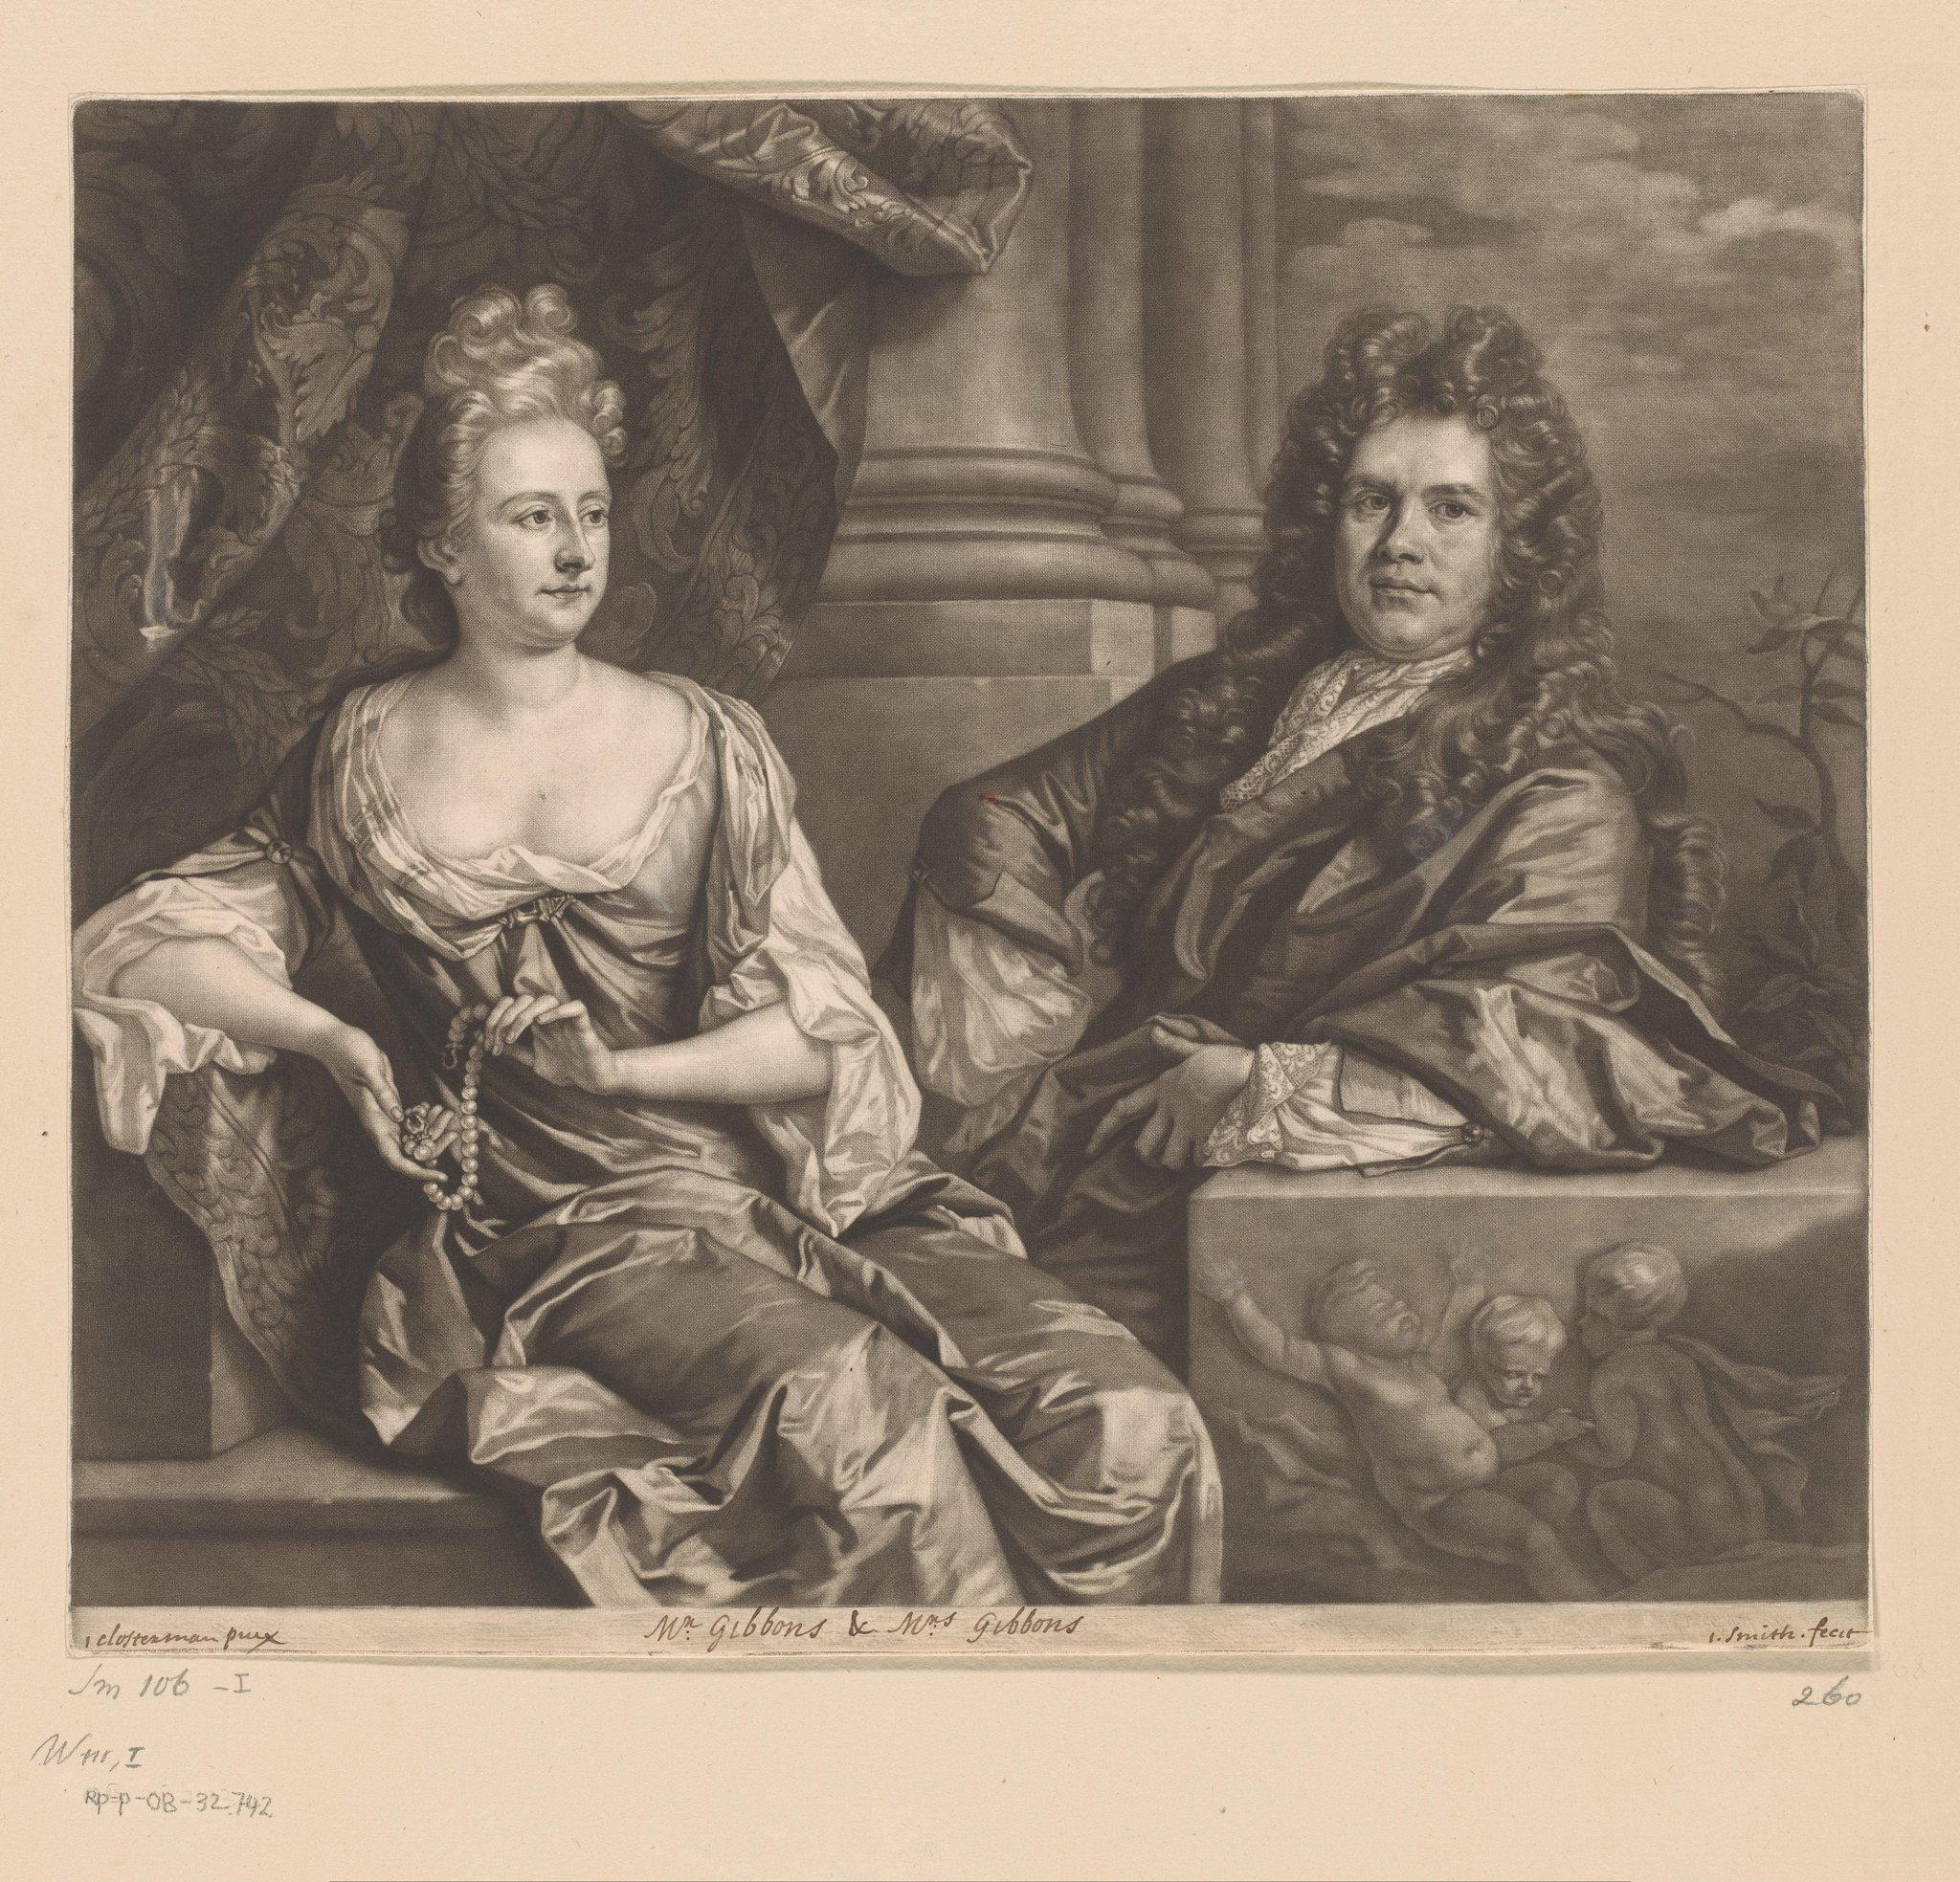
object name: print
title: Portret van Grinling en Elizabeth Gibbons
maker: john smith (prentmaker/ uitgever)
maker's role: print maker, publisher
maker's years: 1652-1743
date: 1691-1742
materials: paper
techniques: mezzotint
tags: london, sculptor, grinling gibbons, historical persons, couple of lovers, cupids: 'amores', 'amoretti', 'putti'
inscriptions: collector's mark: Lugt 240, annotation: ‘Closterman pinx/ Mr. Gibbons & Mrs. Gibbons/ I. Smith fecit’